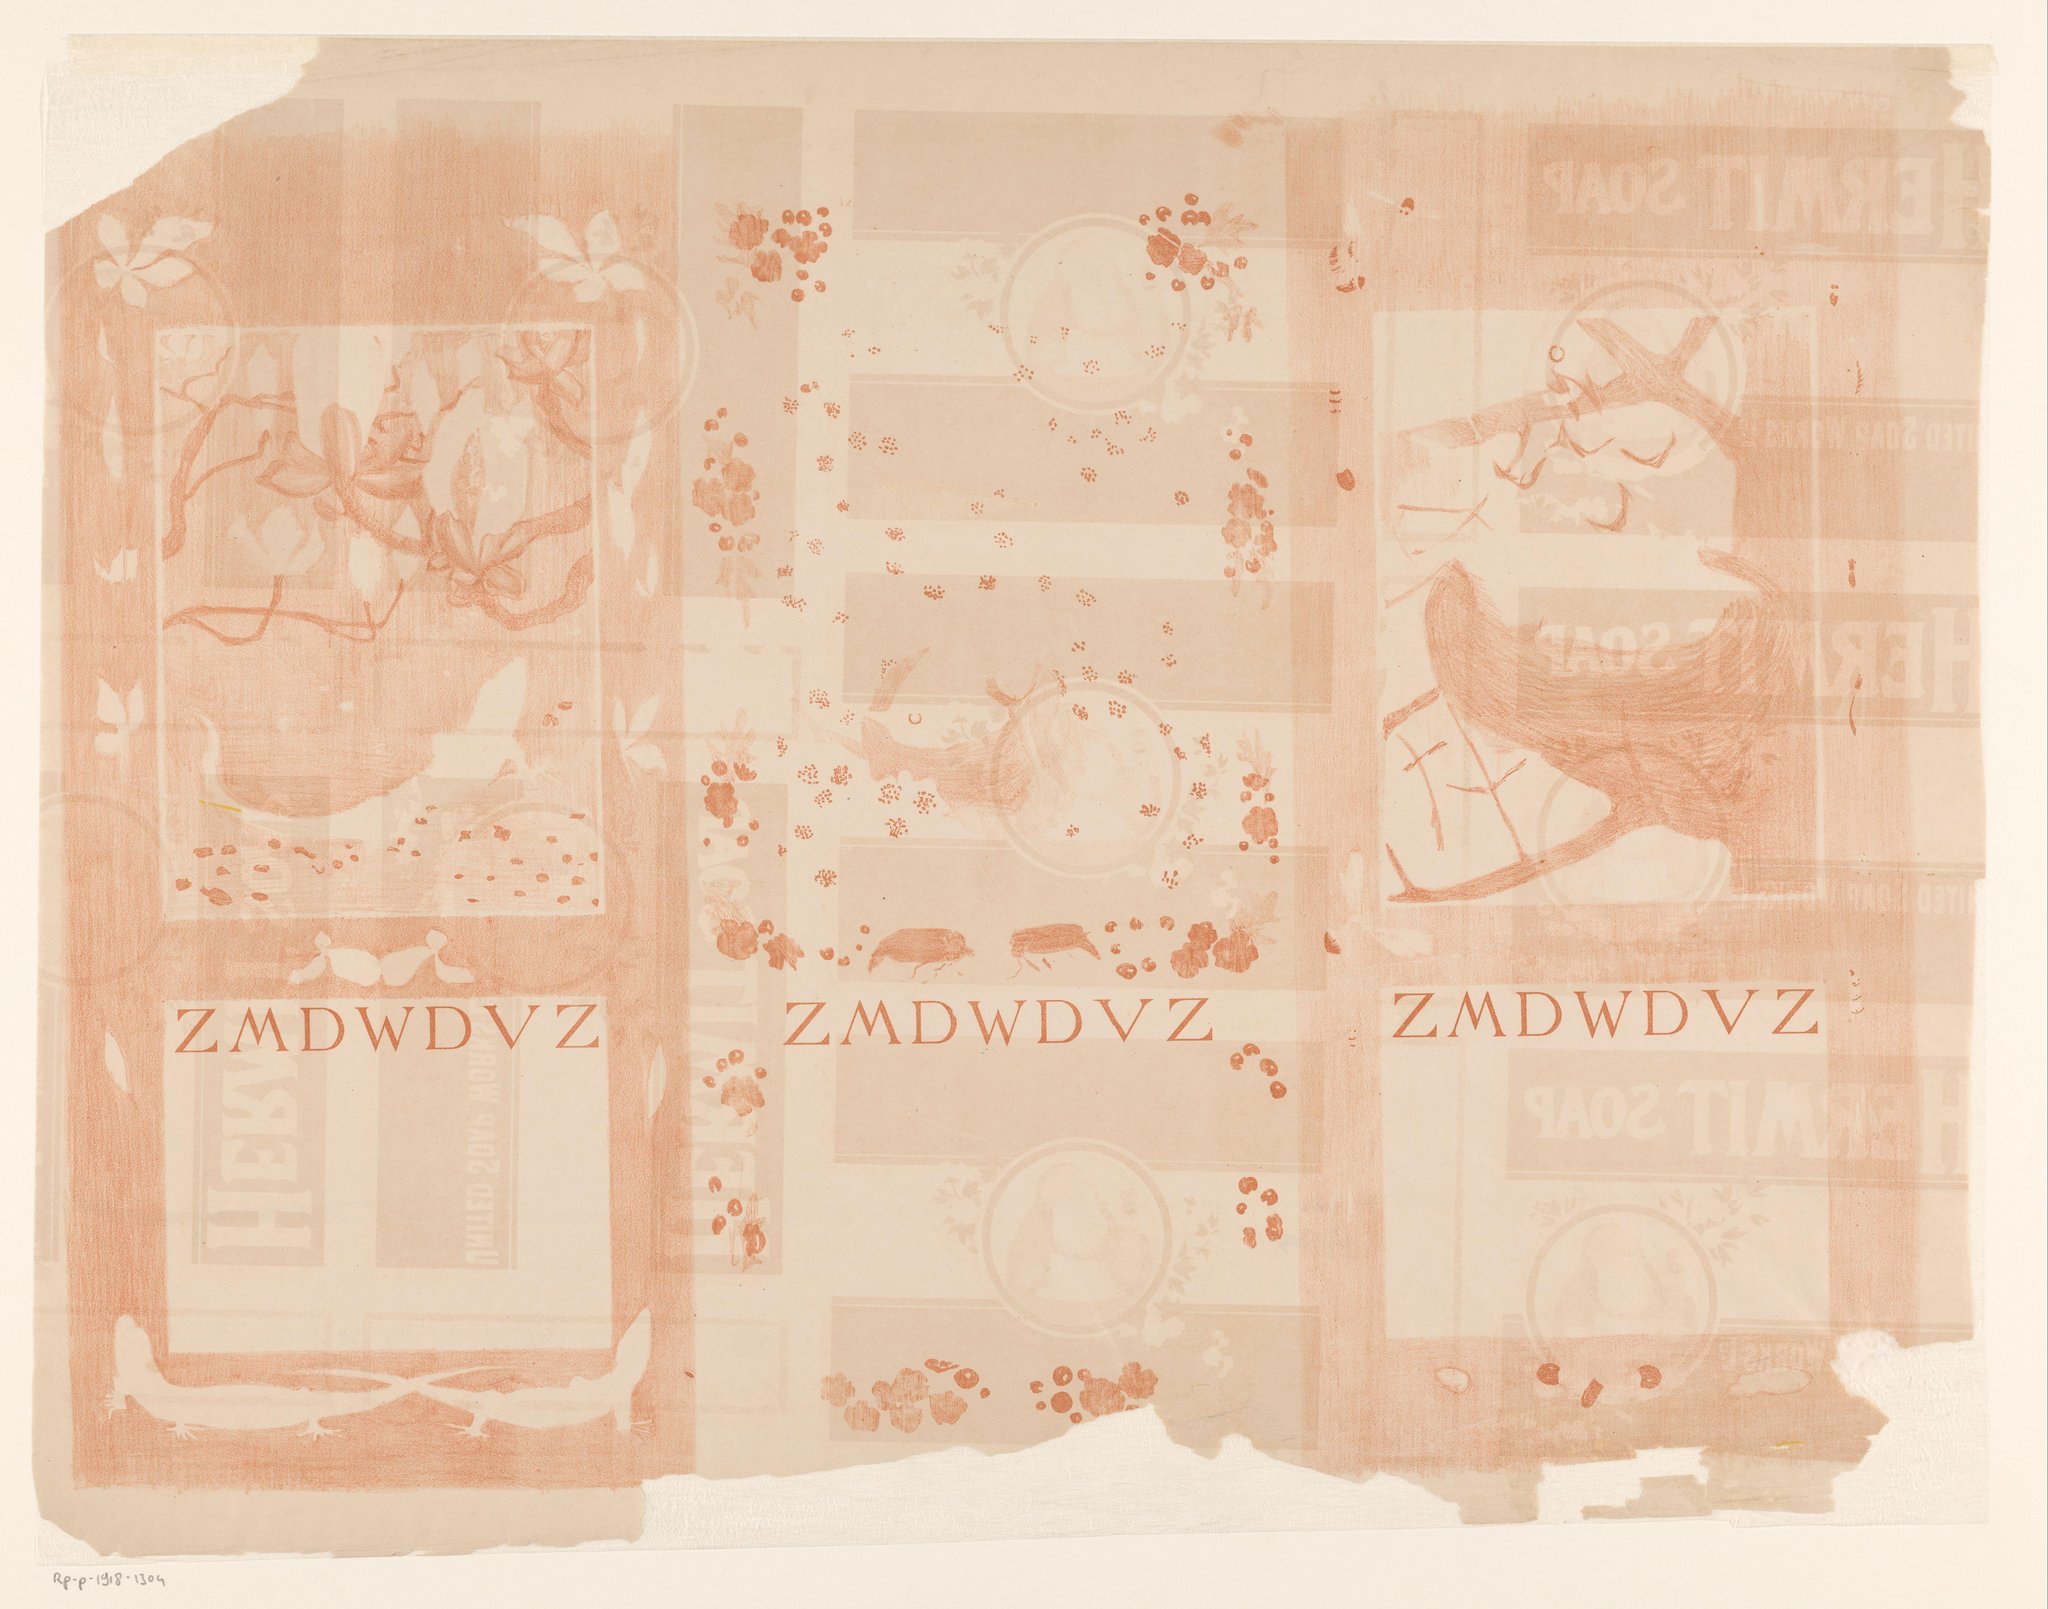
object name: print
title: Kalenderbladen van april, mei en juni, met hagedis en vogels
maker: theo van hoytema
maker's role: draughtsman, painter, print maker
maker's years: 1863-1917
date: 1901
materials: paper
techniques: lithograph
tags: calendar, almanac, lizards, birds